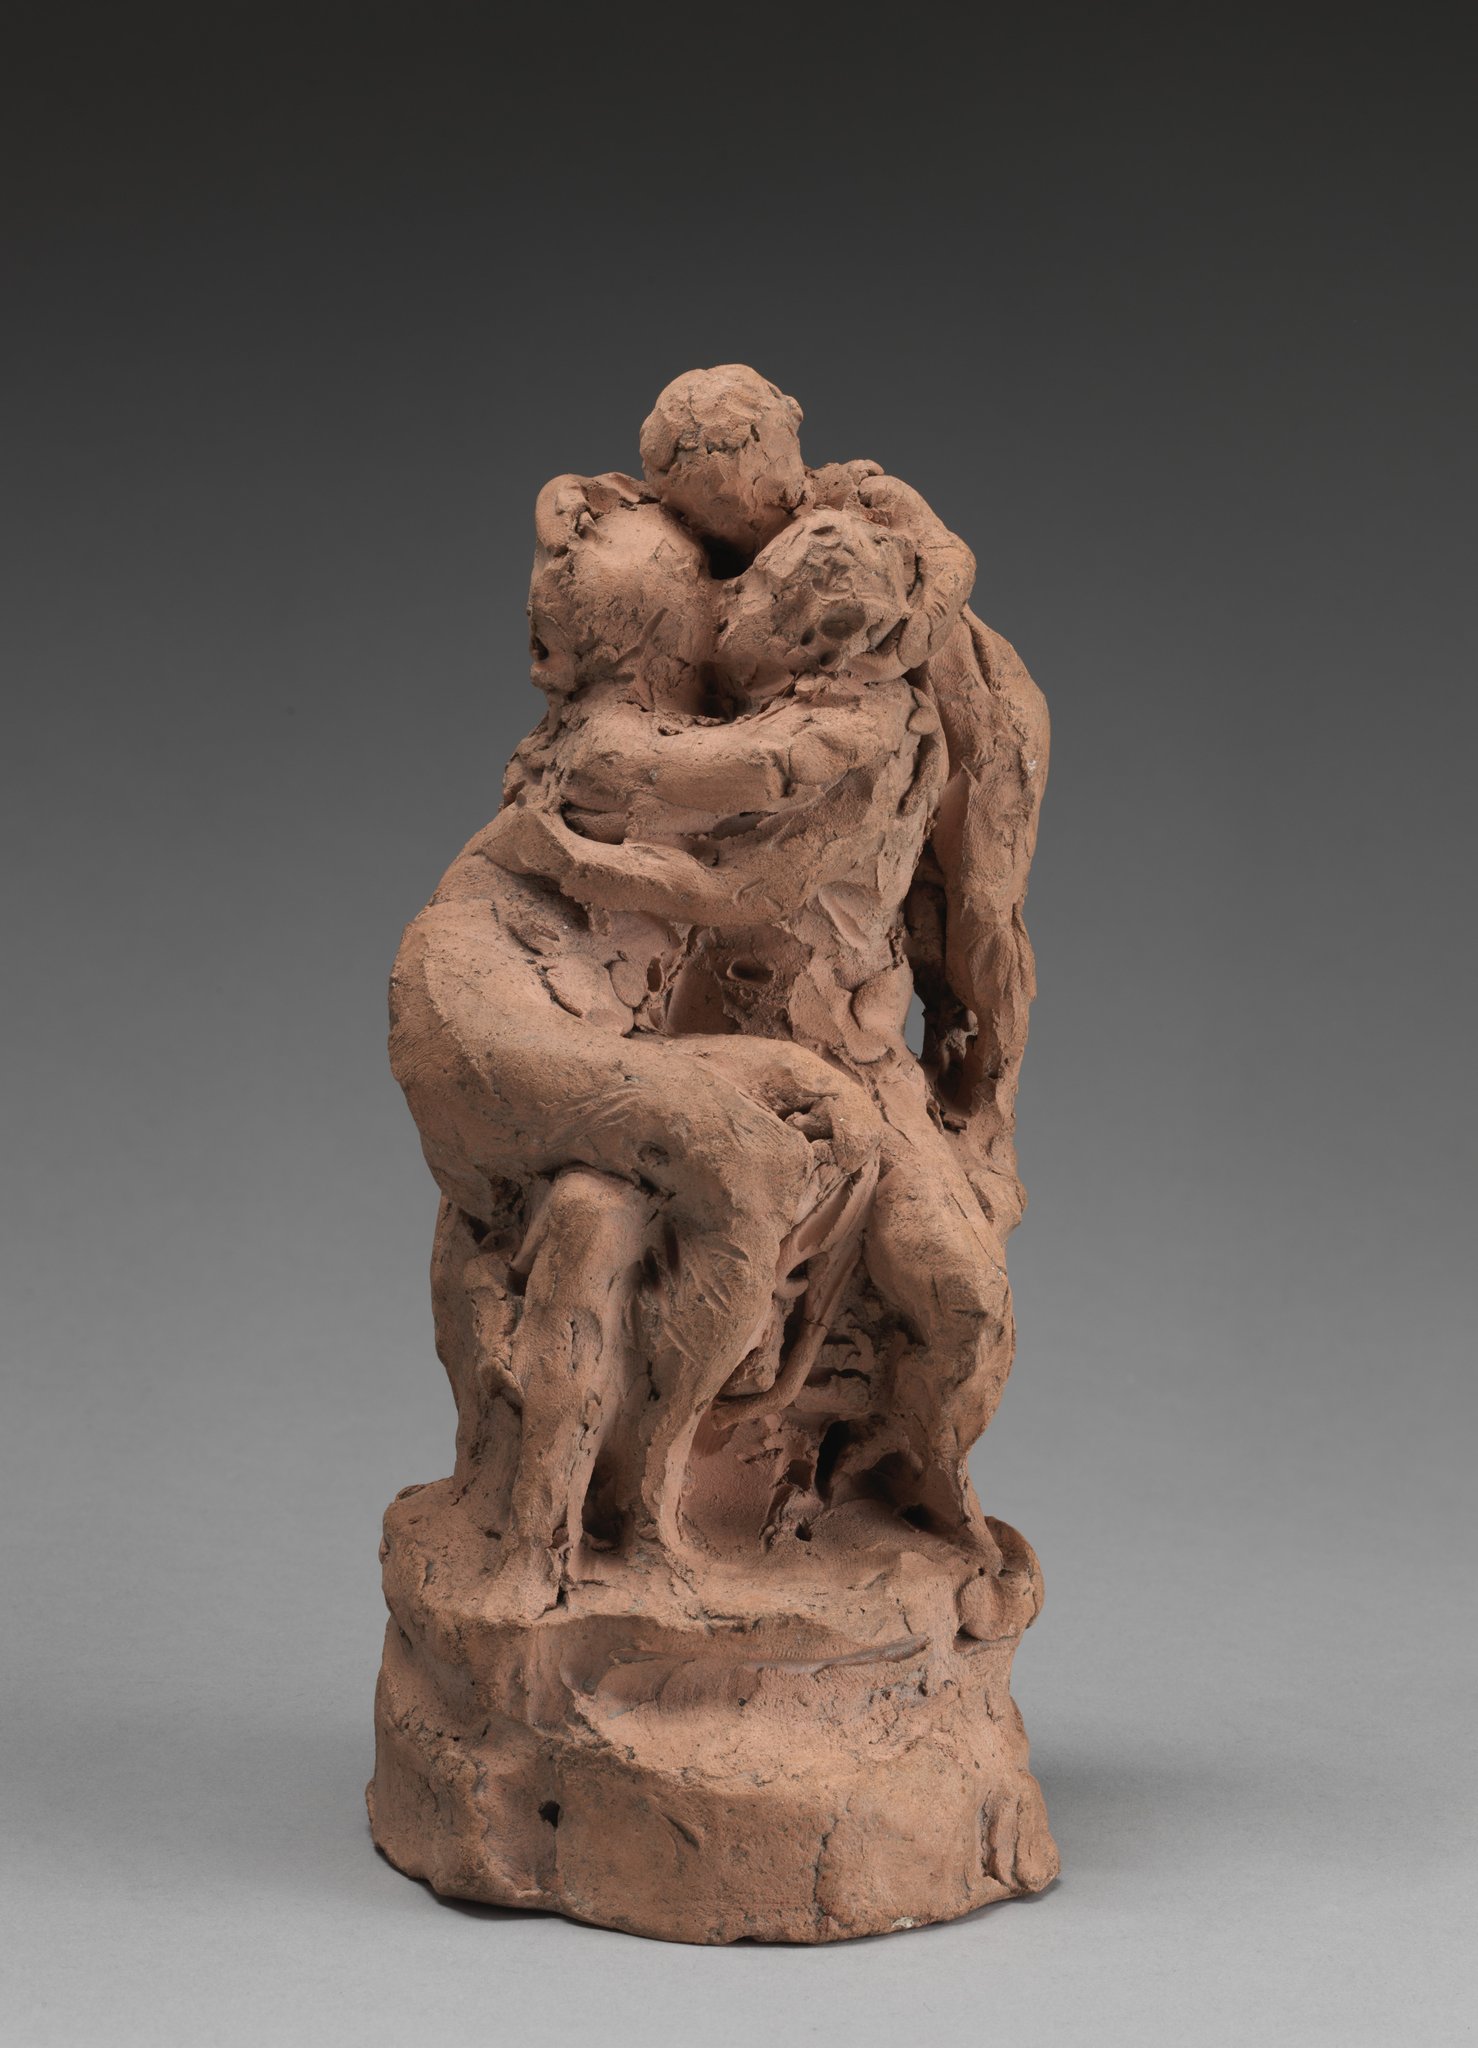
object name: statuette group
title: Le Trait d’Union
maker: jean-baptiste carpeaux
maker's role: maker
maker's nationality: french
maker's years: 1827-1875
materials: terracotta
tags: children,men,women